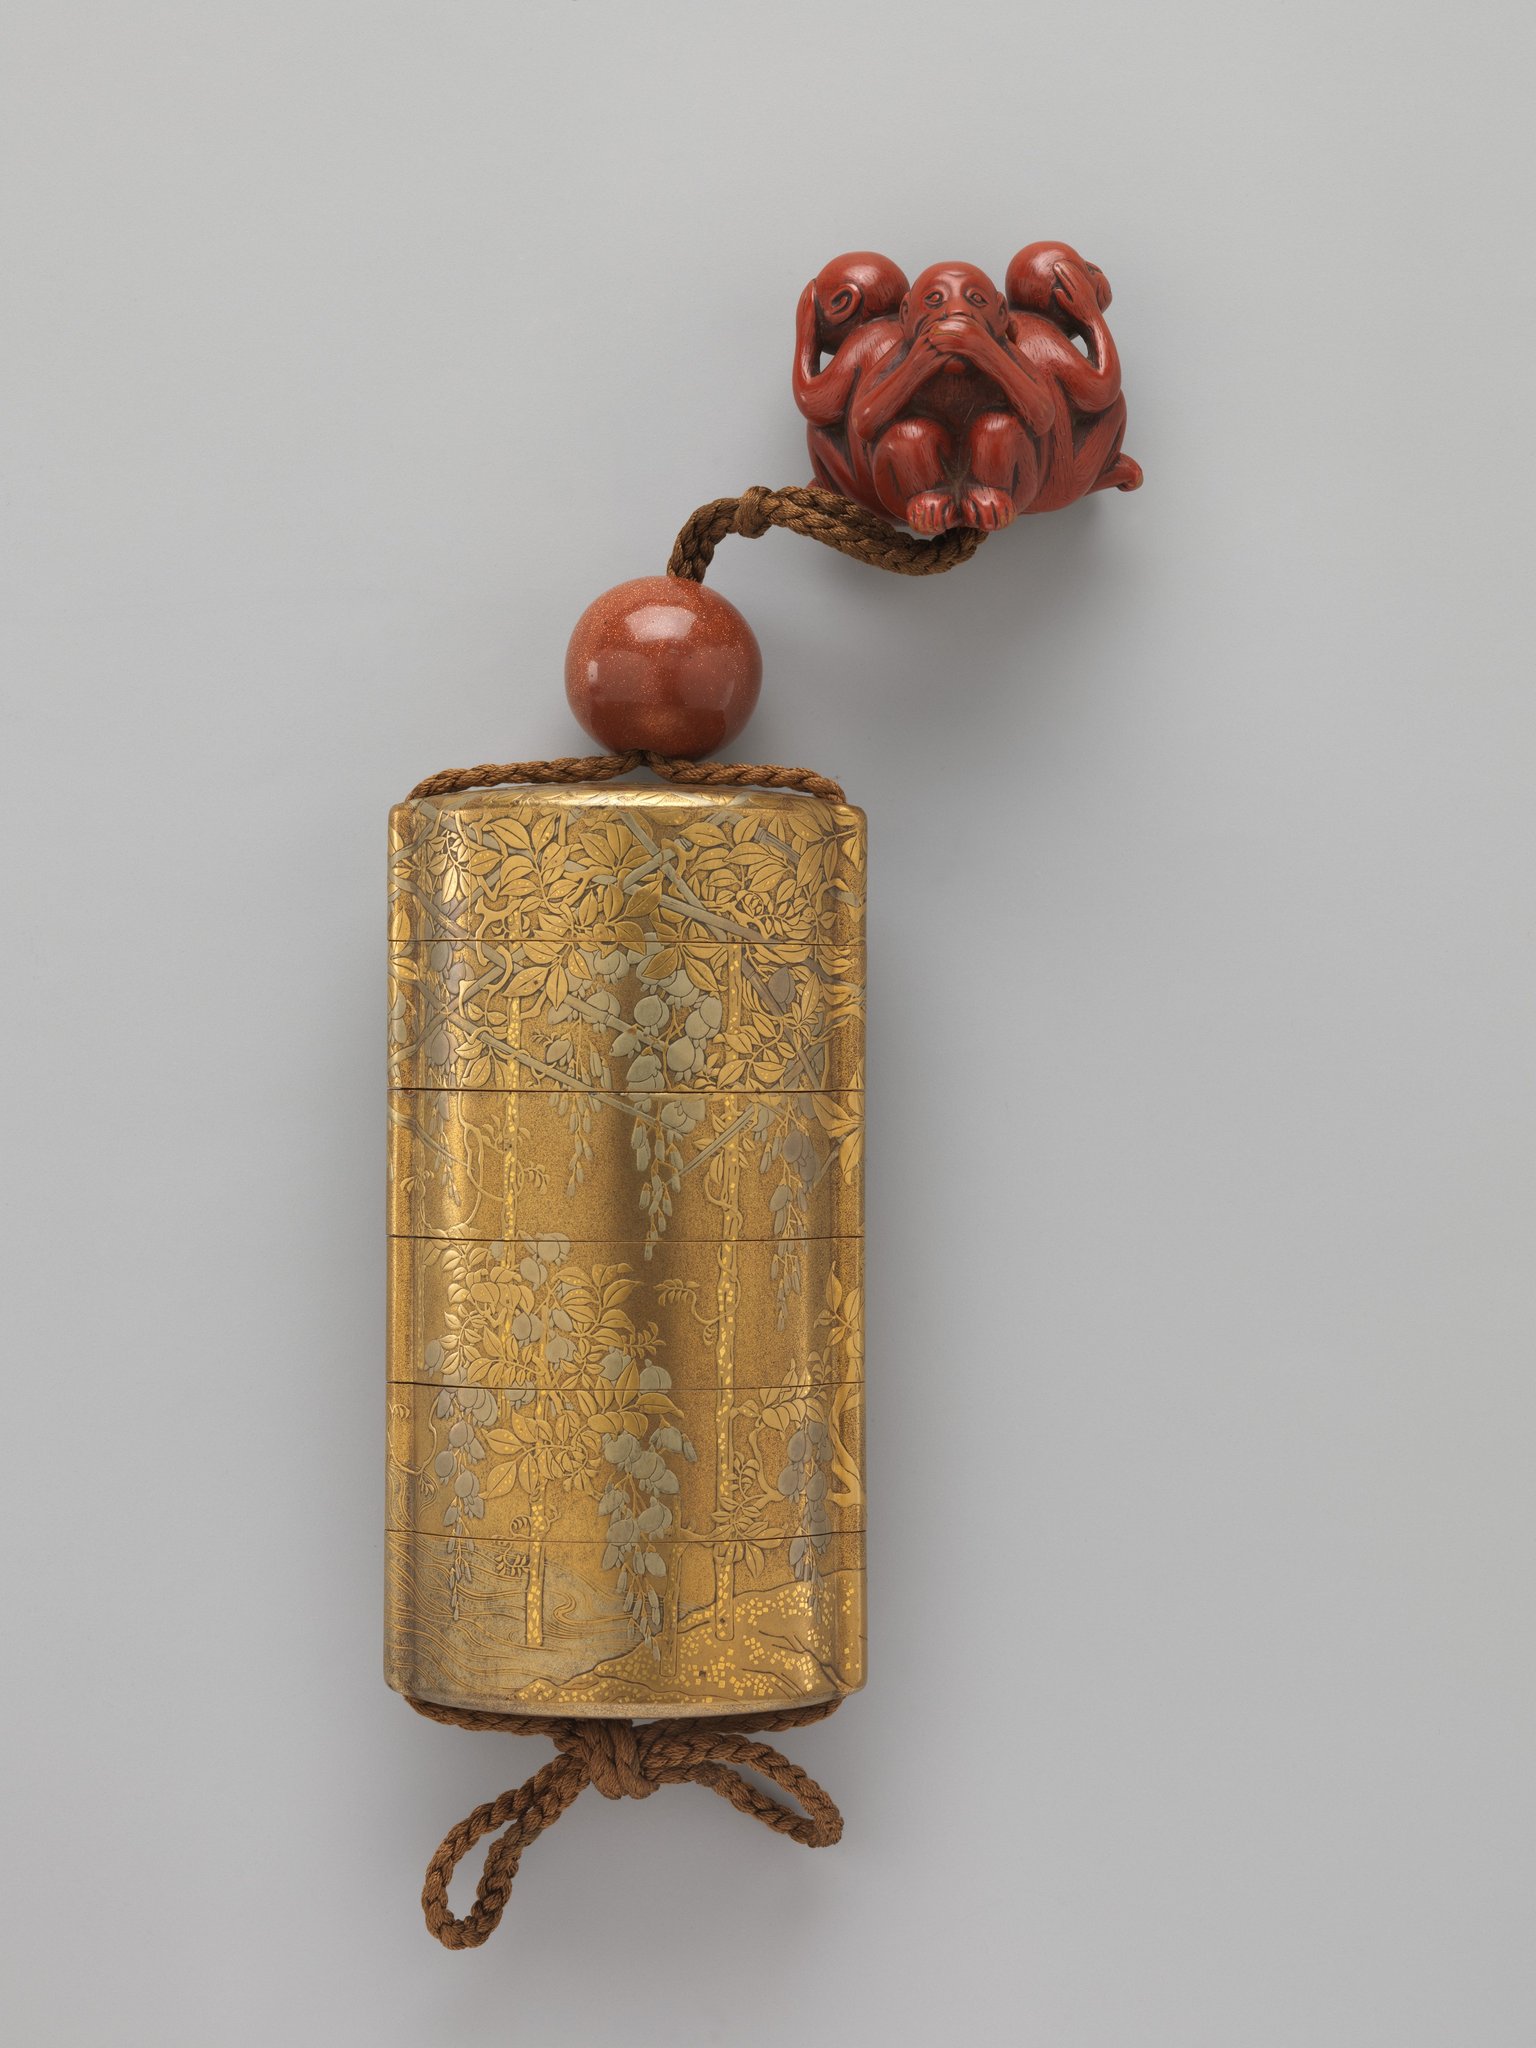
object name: inrō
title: Inrō with Wisteria Trellis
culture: japanese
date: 1834-1866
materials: gold, gold foil, lacquer, silver, wood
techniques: carving, hiramakie, lacquer, maki-e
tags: monkeys,plants